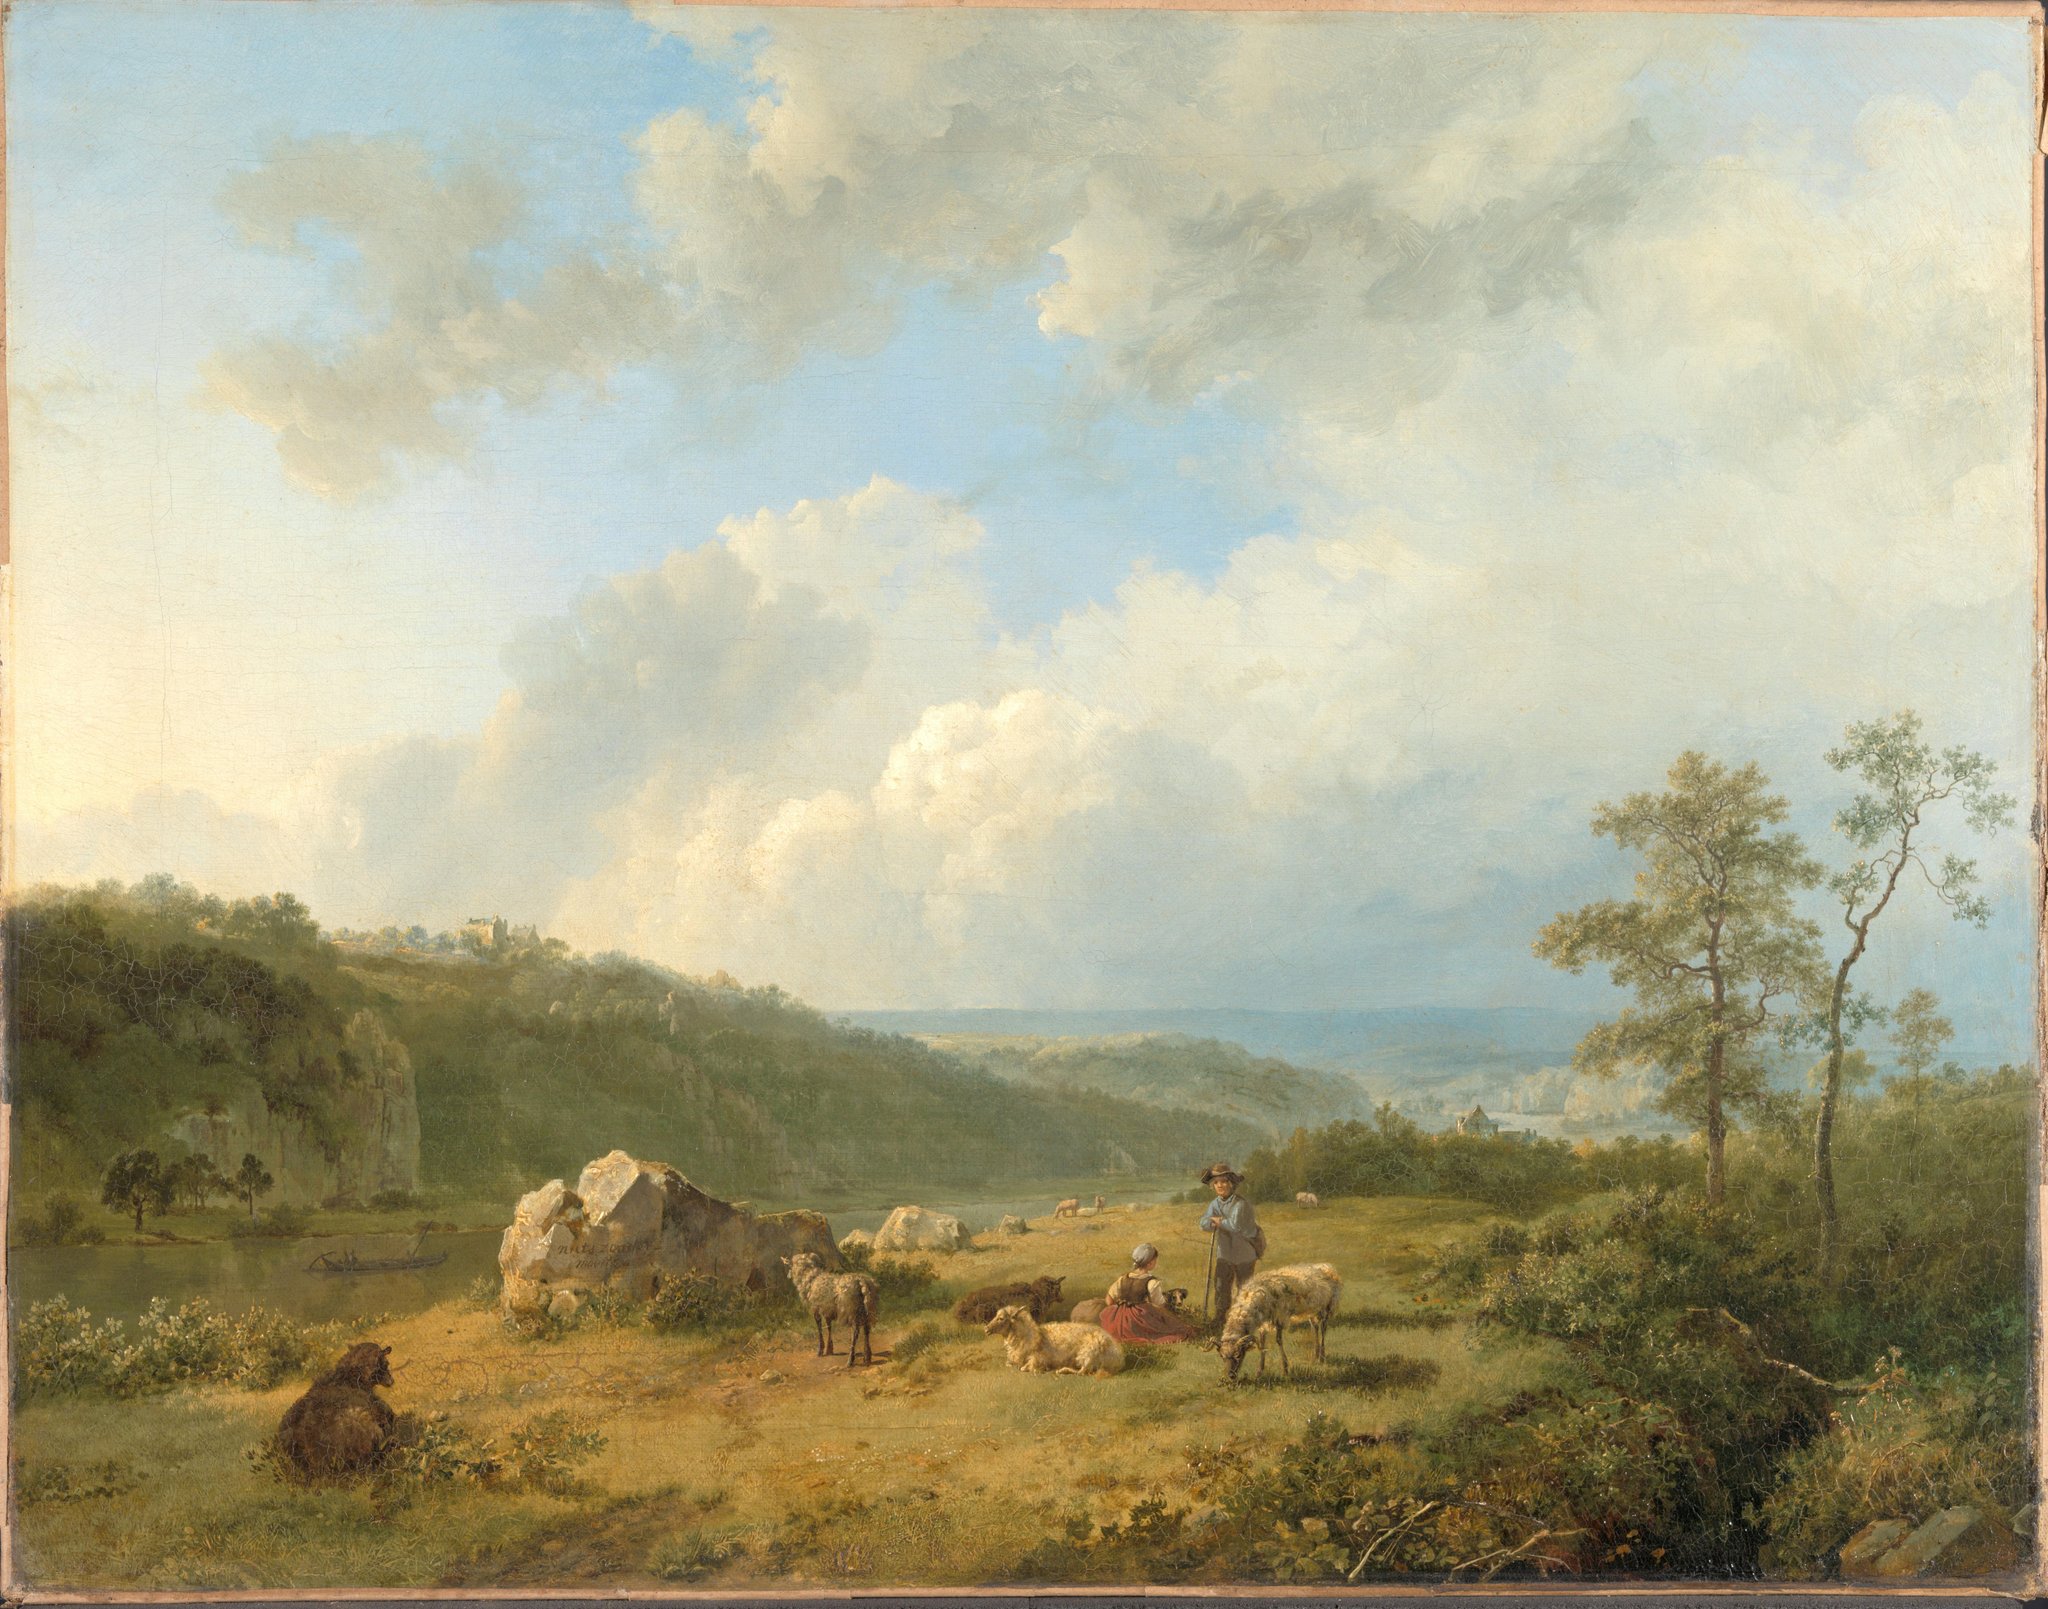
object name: painting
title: Landscape with a Rainstorm Threatening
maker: barend cornelis koekkoek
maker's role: draughtsman, painter, print maker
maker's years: 1803-1862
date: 1825-1829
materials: canvas, oil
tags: low hill country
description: These shepherds seem to enjoy a simple and peaceful existence in a wide meadow. However, the life of farmers and shepherds was harder in reality. Before 1850, artists did not paint outdoors: paint tubes did not yet exist, so working en plein air was impractical. Therefore, artists used sketches of what they saw to create landscape compositions back in their studio.